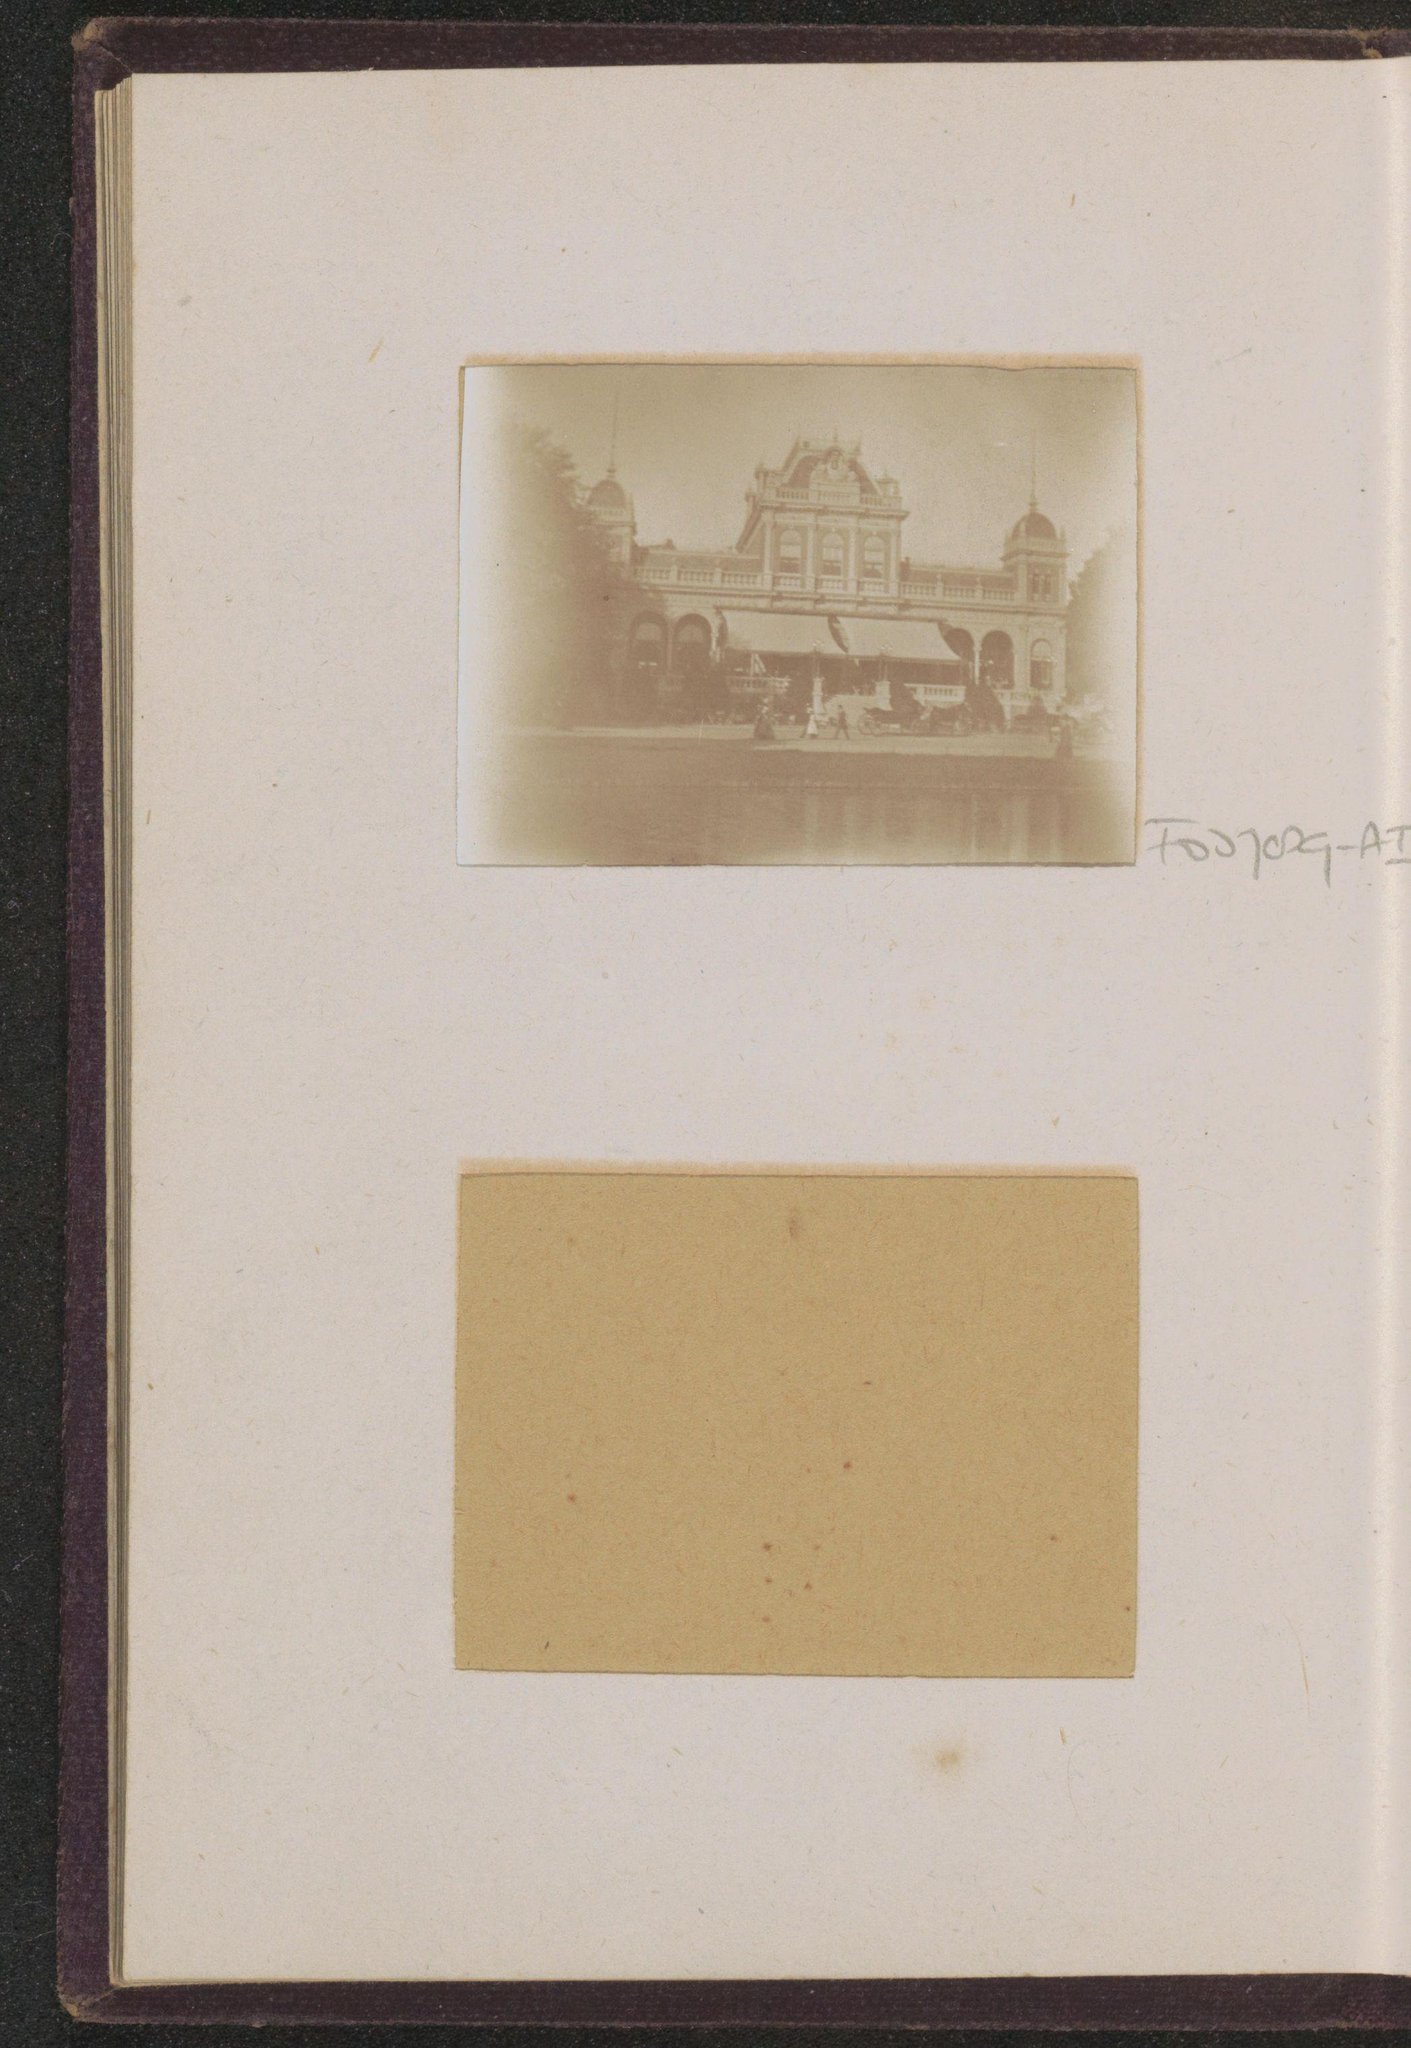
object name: photograph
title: Vondelparkpaviljoen in Amsterdam met wandelaars en wachtend rijtuig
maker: Anonymous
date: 1890-1905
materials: paper, photographic support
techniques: collodion silver print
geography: vondelpark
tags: public gardens, park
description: Onderdeel van Fotoalbum met 35 foto's van Amsterdam, personen en dieren.